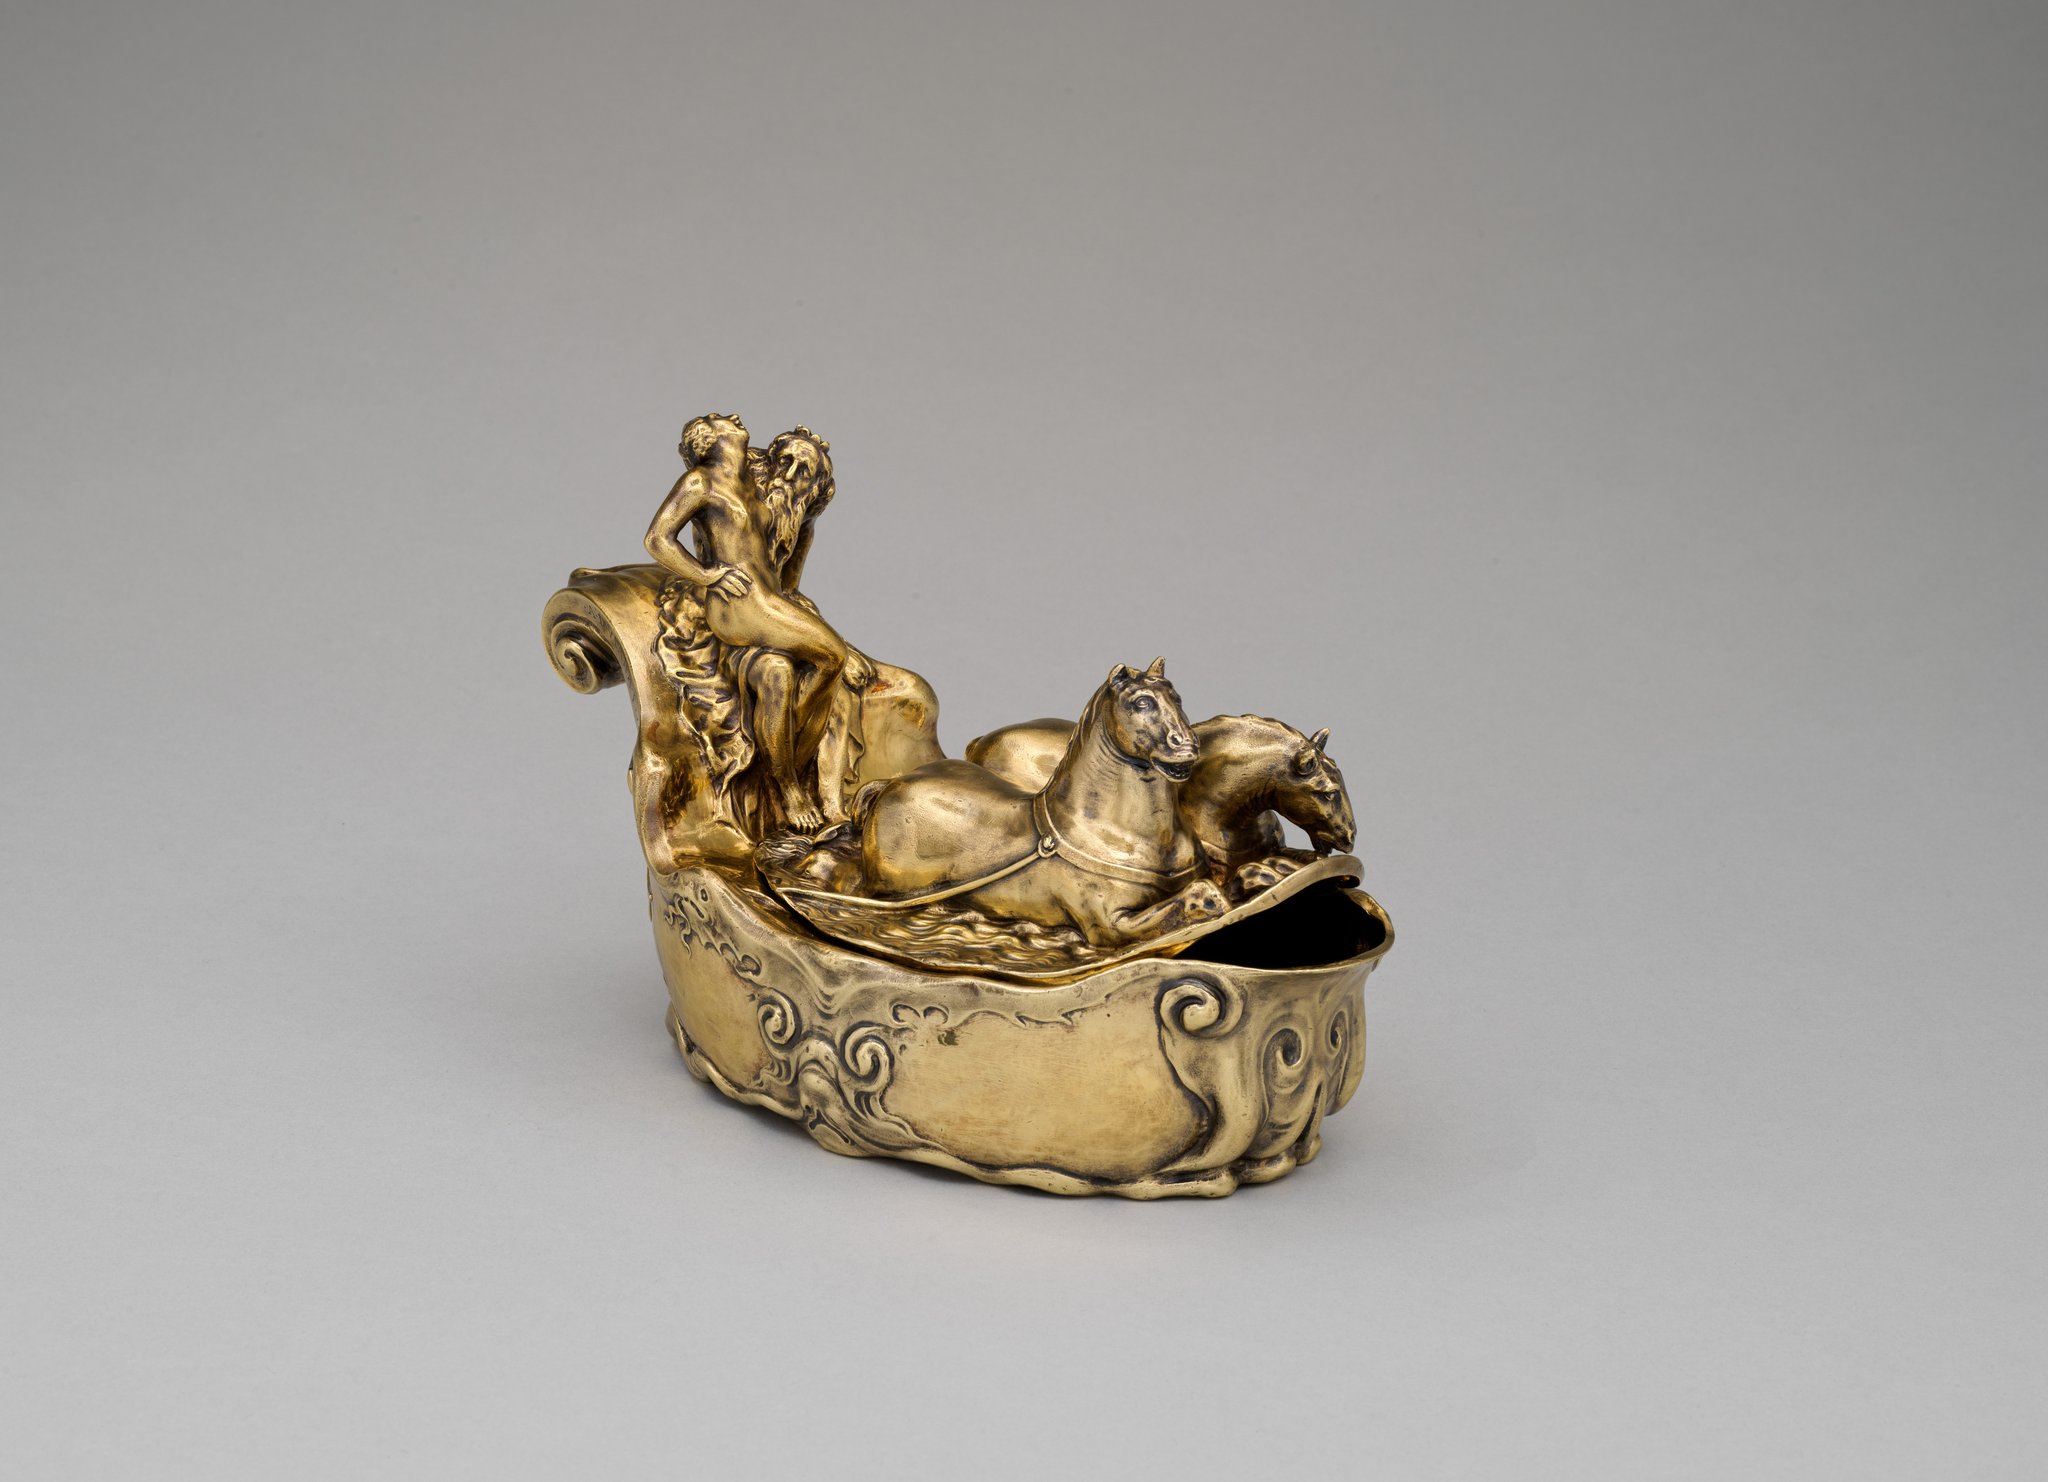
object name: sauceboat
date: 1801-1900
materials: silver gilt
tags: men,female nudes,horses